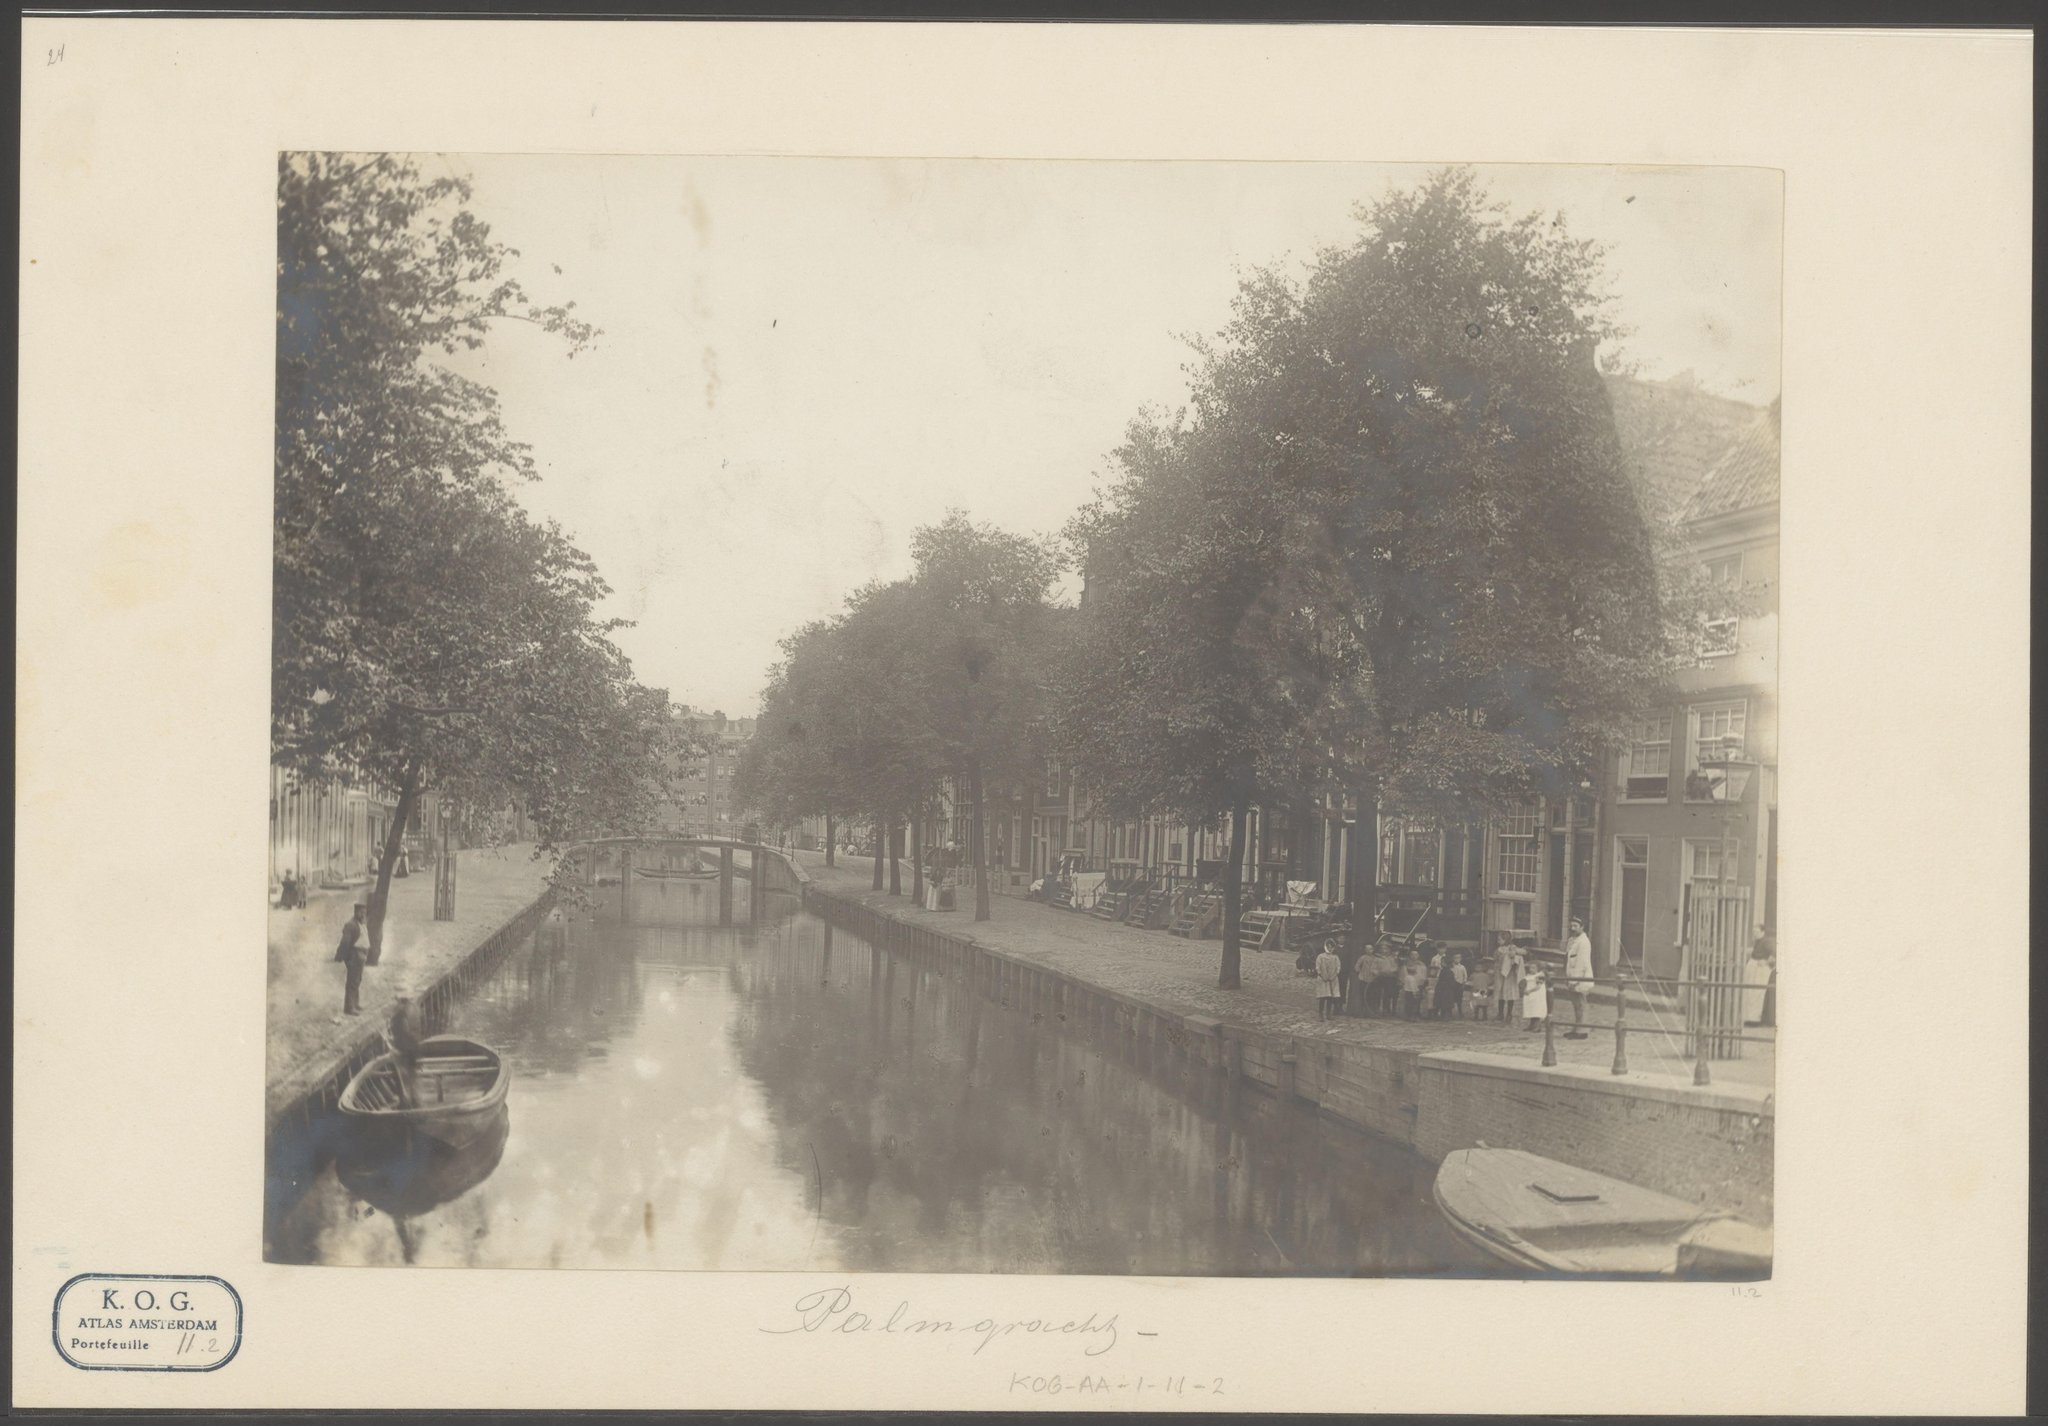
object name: photograph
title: Gezicht op de Palmgracht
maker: Anonymous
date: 1880-1950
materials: paper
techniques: gelatin silver print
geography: amsterdam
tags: city-view in general; 'veduta', canal, bridge in city across river, canal, etc., street, boat propelled by man or animal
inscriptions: inscription: ‘Palmgracht-’, collector's mark: ‘11.2’ Lugt 1641b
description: Onderwerpsrubriek binnen de Atlas Amsterdam: Paleisstraat, Palmgracht, Papenbrugsteeg, Passeerdersgracht, Peperstraat, Pieterspoort (St.), Pieterssteeg (St.), Plantage, Prinseneiland.